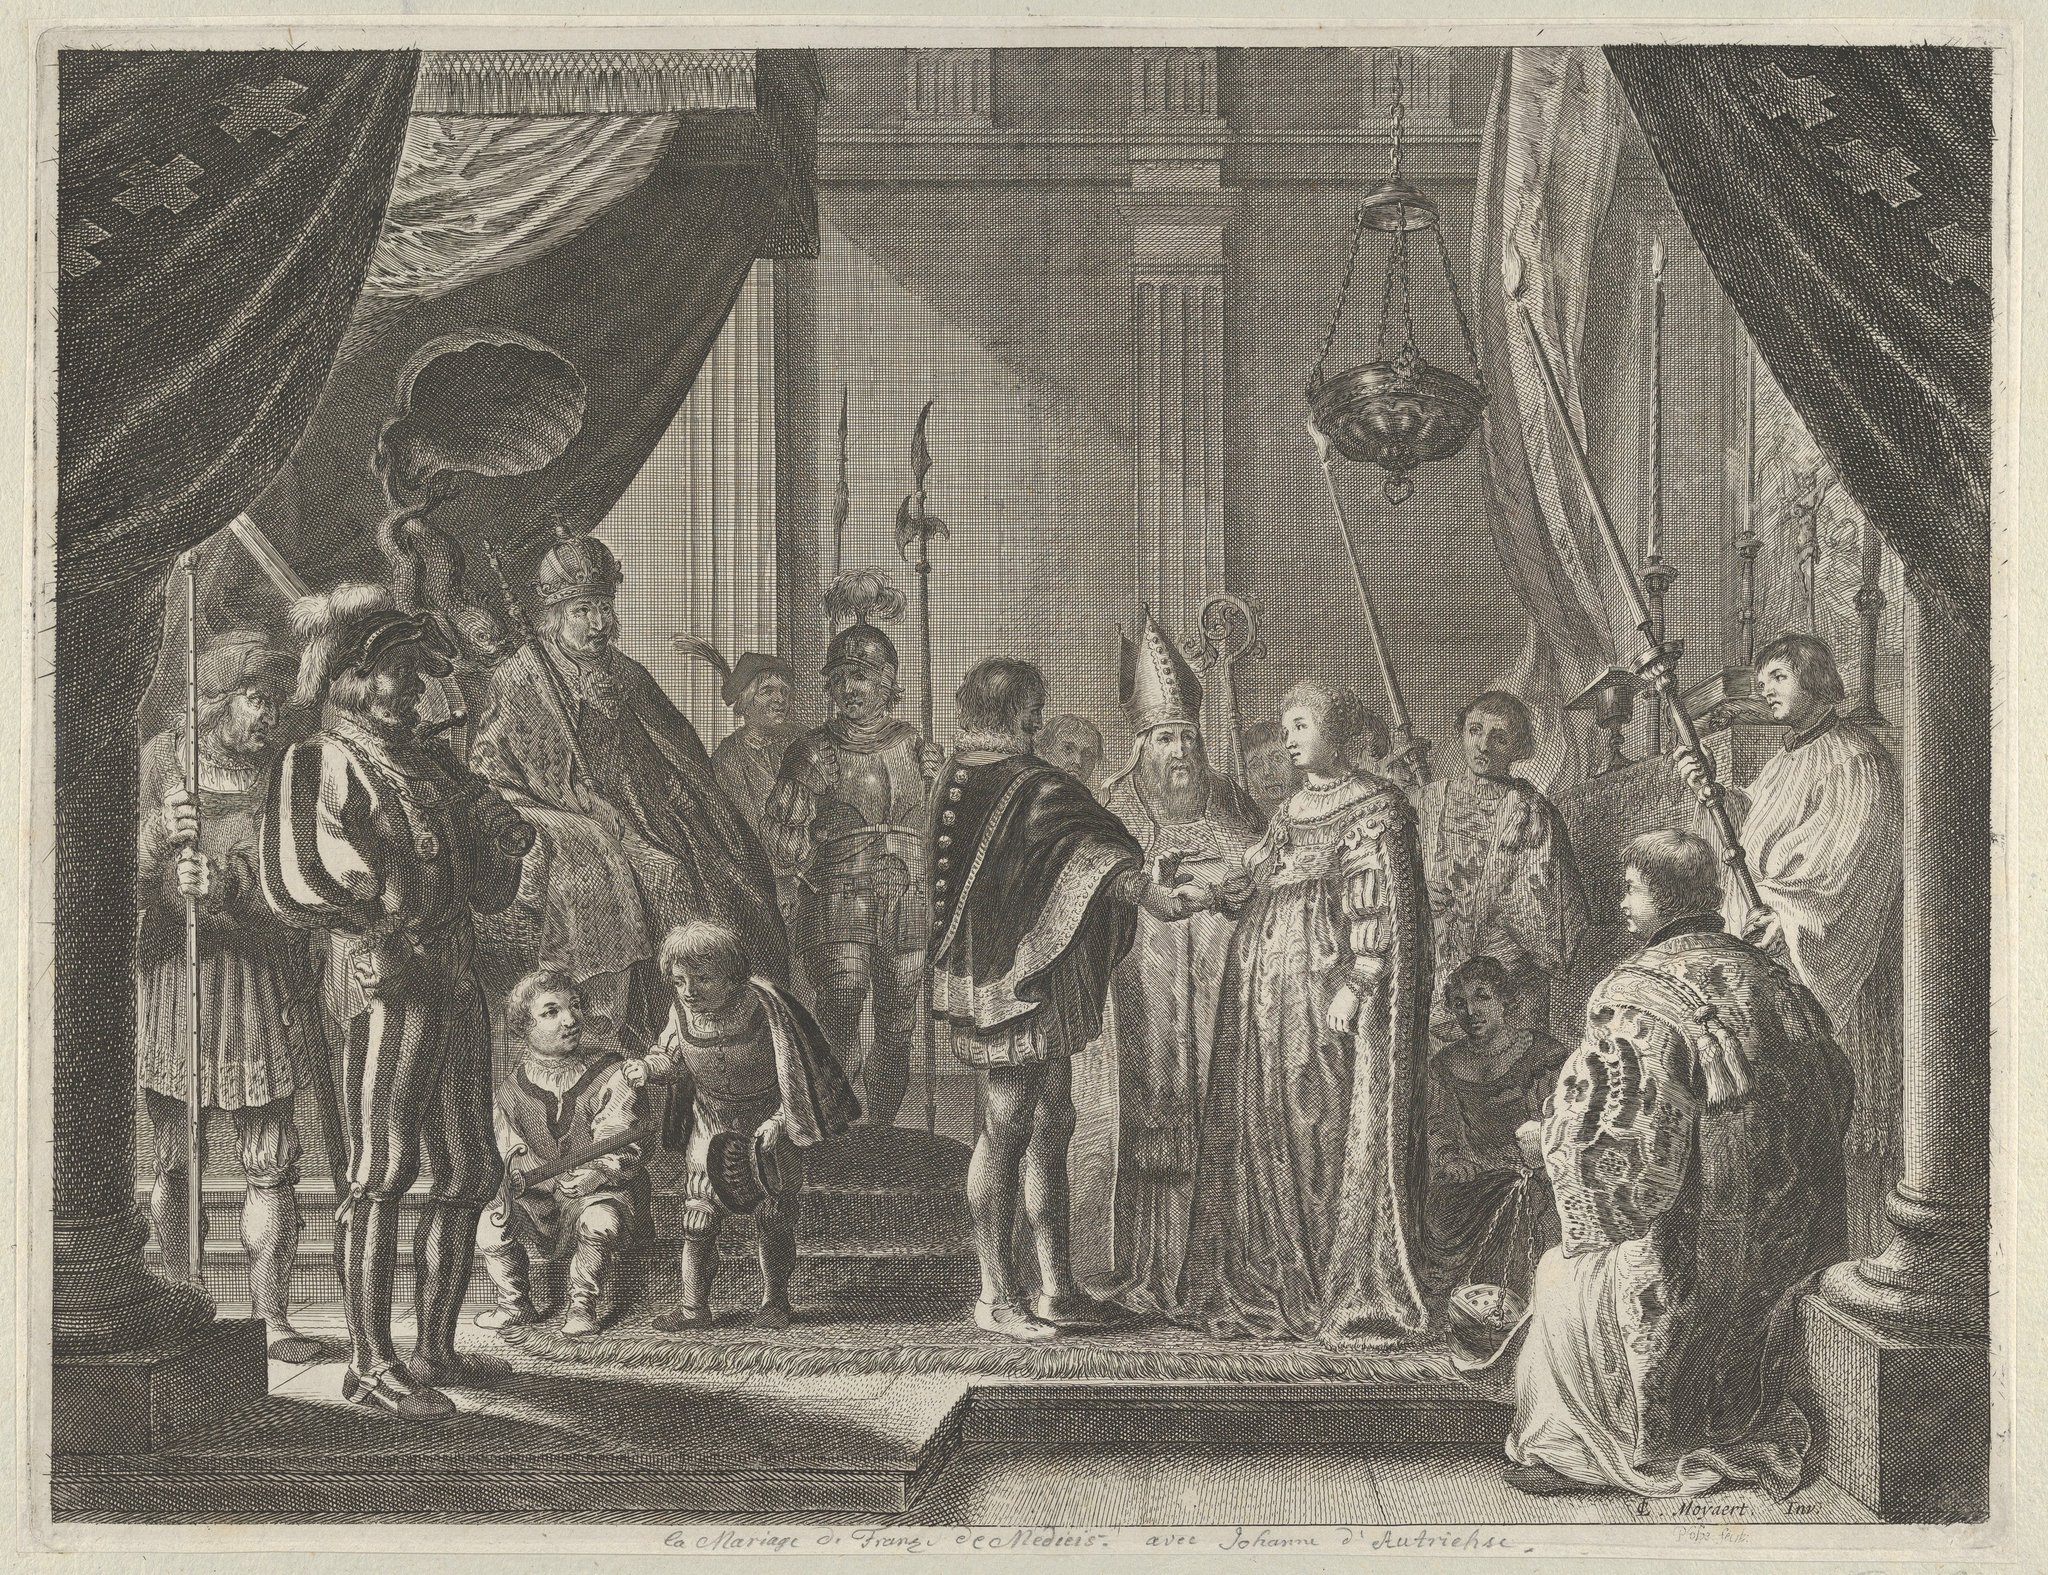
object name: print, fete, ornament architecture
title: Plate 7: The Marriage of Francisco I de Medici and Johanna of Austria, from Caspar Barlaeus, "Medicea Hospes"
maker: pieter nolpe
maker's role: artist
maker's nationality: dutch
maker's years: 1613-1614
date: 1638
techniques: etching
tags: men,women,weddings